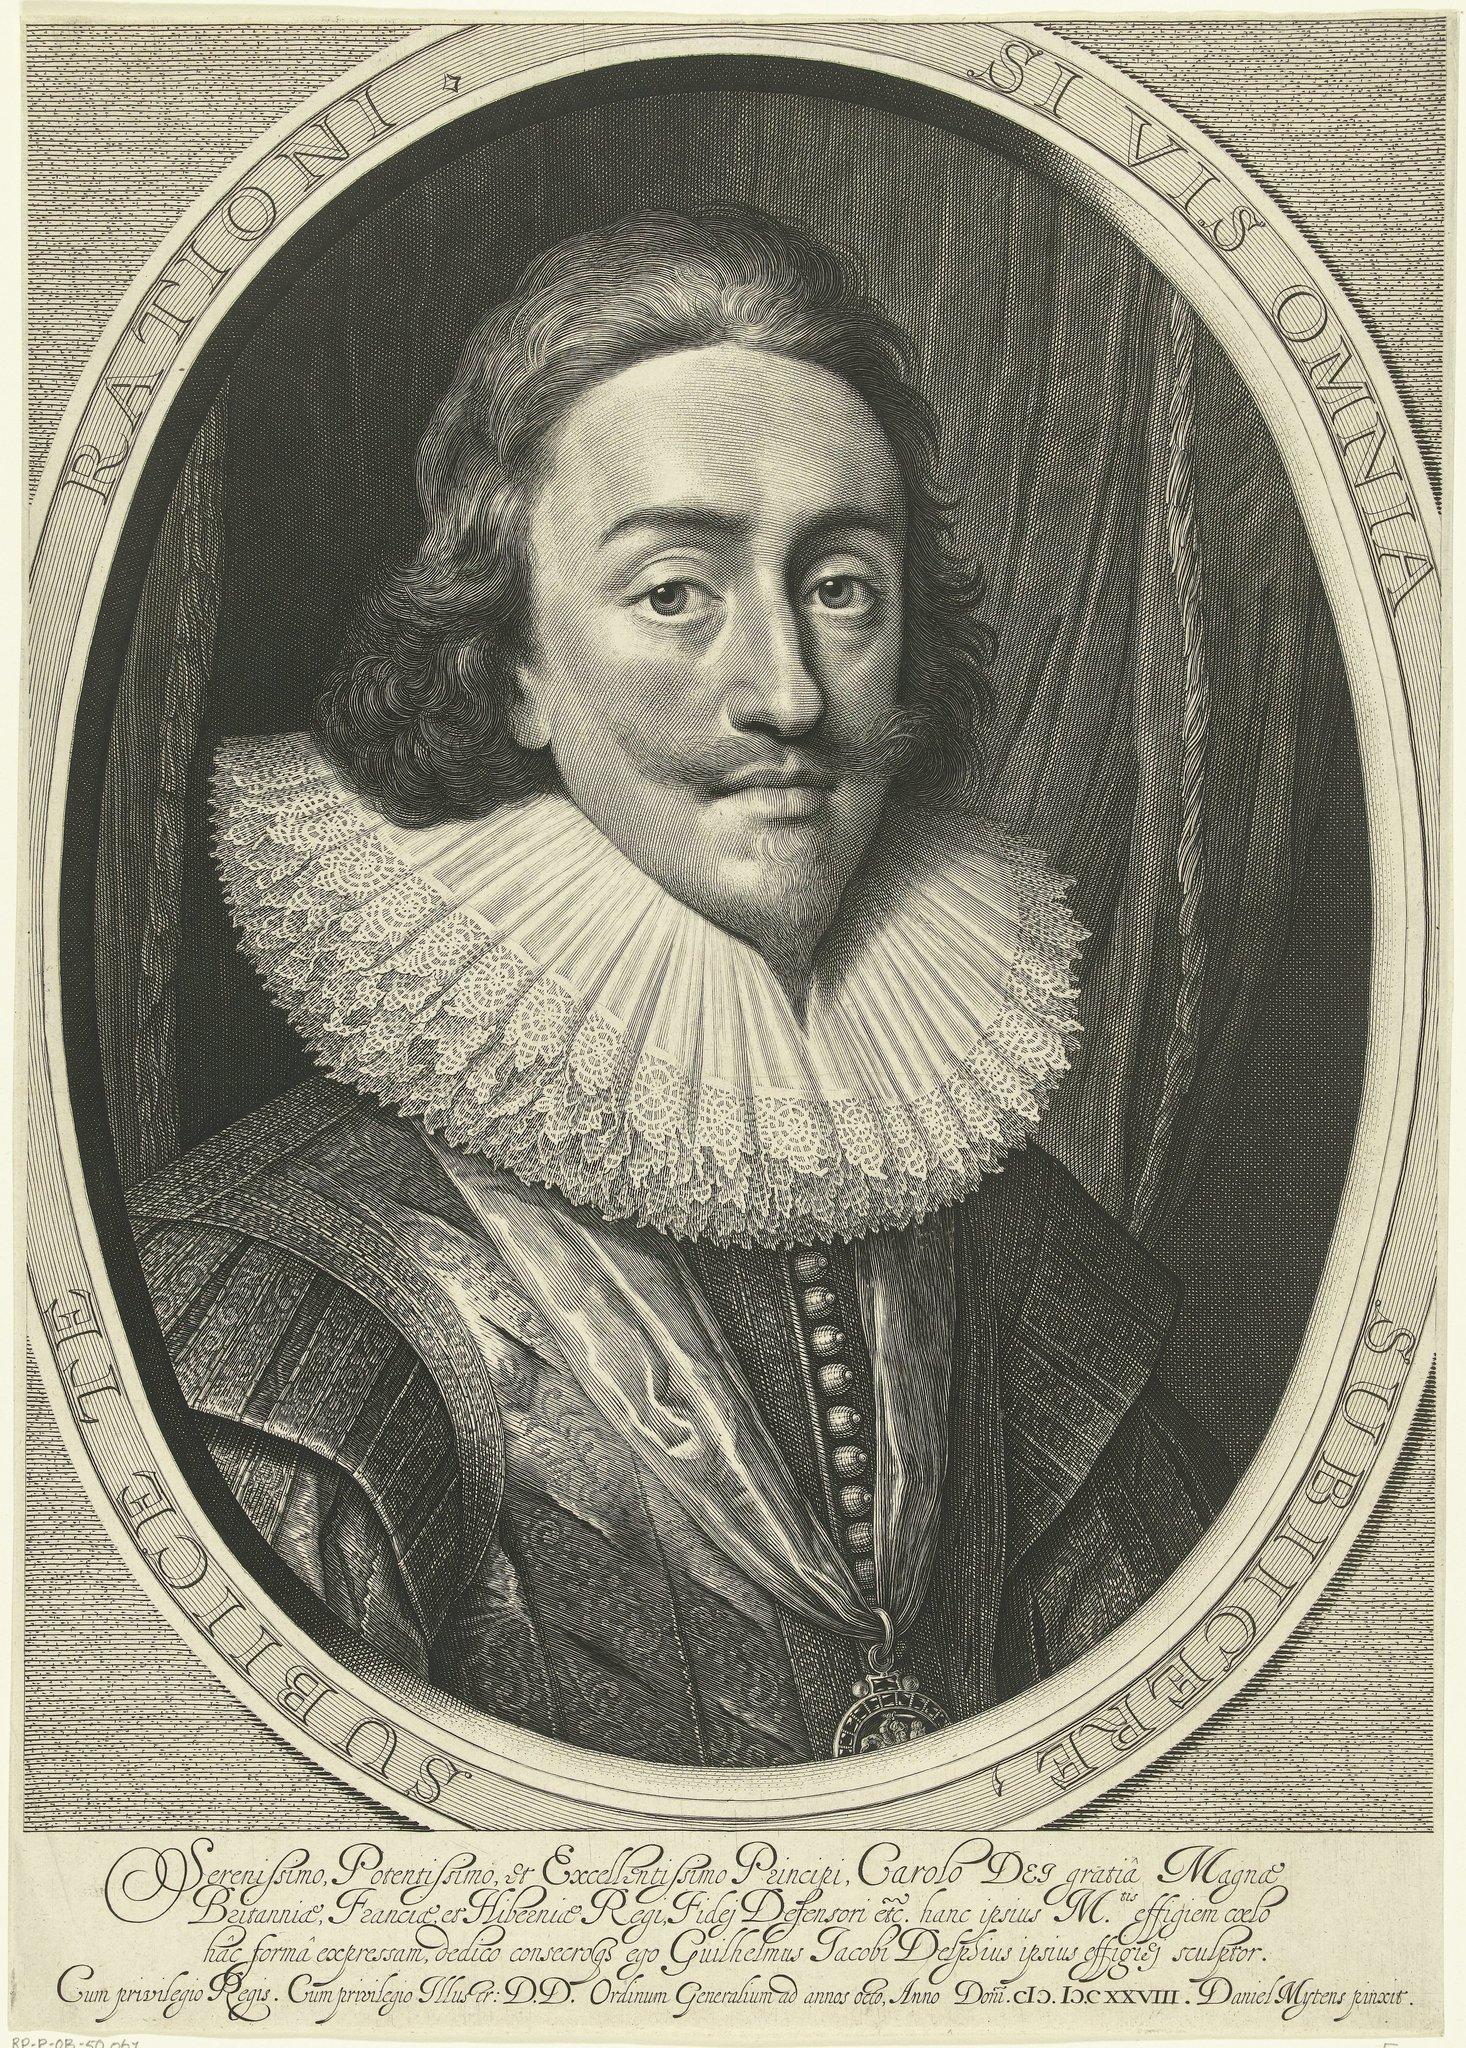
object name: print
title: Portret van Karel I, koning van Engeland in ovaal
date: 1628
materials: paper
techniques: engraving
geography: delft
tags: london, karel i (koning van engeland), ruler, sovereign, neck-gear: collar (+ men's clothes)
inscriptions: collector's mark: Lugt 2228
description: Portret van Karel I, koning van Engeland, borststuk in ovaal met plooikraag en medaillon met heilige Georgius de Grote. Motto op ovale omlijsting, Latijns opschrift in ondermarge.